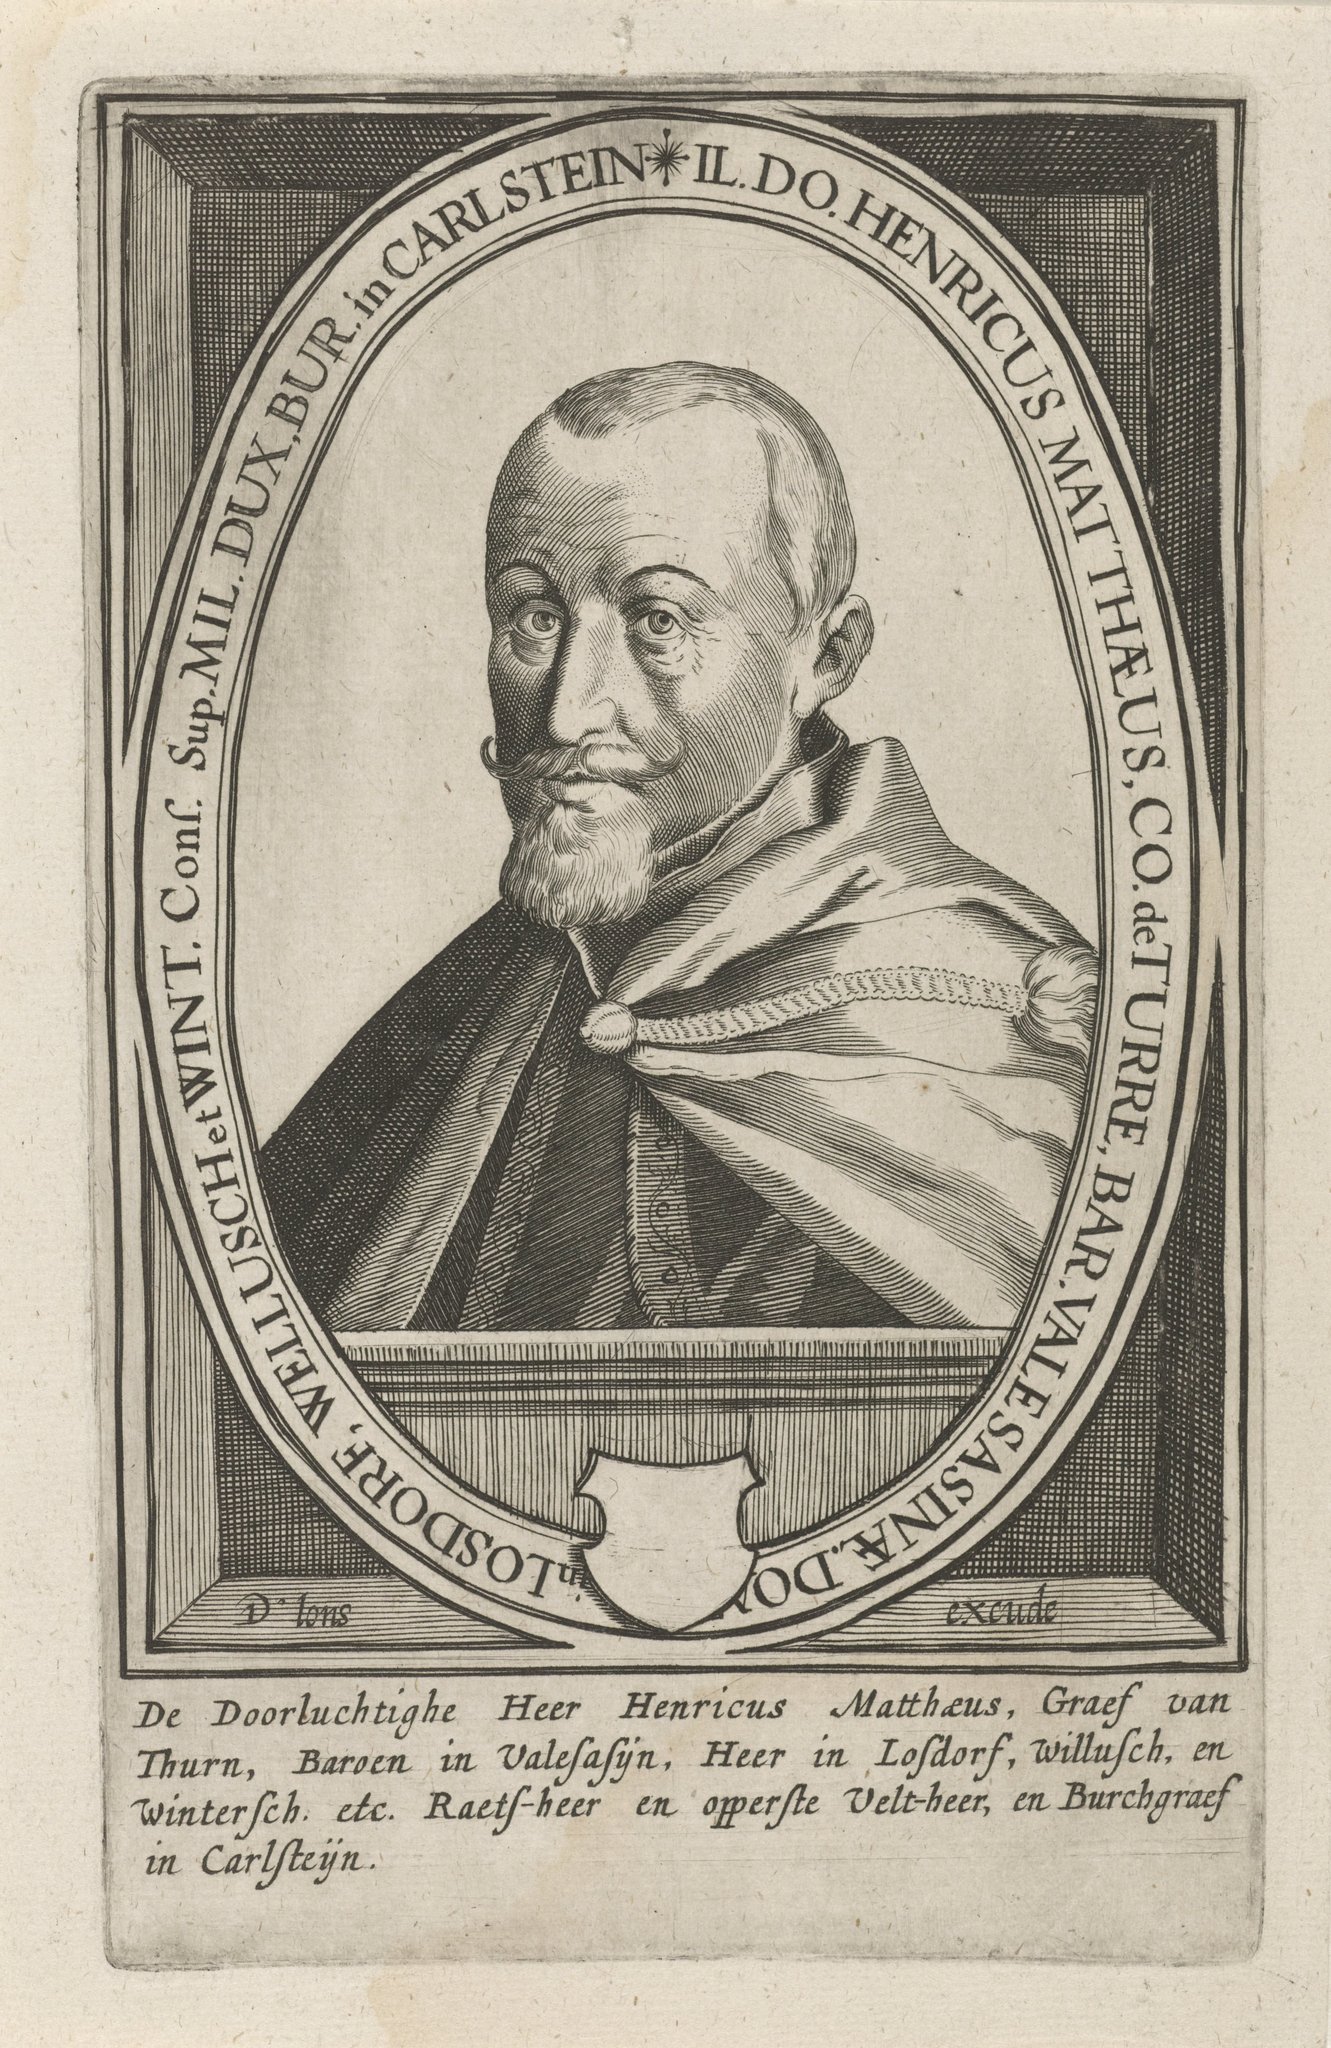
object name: print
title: Portret van Henrik Matthias, graaf van Thurn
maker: dirk eversen lons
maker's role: print maker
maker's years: 1599-1686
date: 1609-1686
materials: paper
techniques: engraving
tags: henrik matthias von thurn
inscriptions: collector's mark: Lugt 2228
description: Portret van Henrik Matthias, graaf van Thurn. Met nog in te vullen familiewapen en een vierregelig onderschrift.